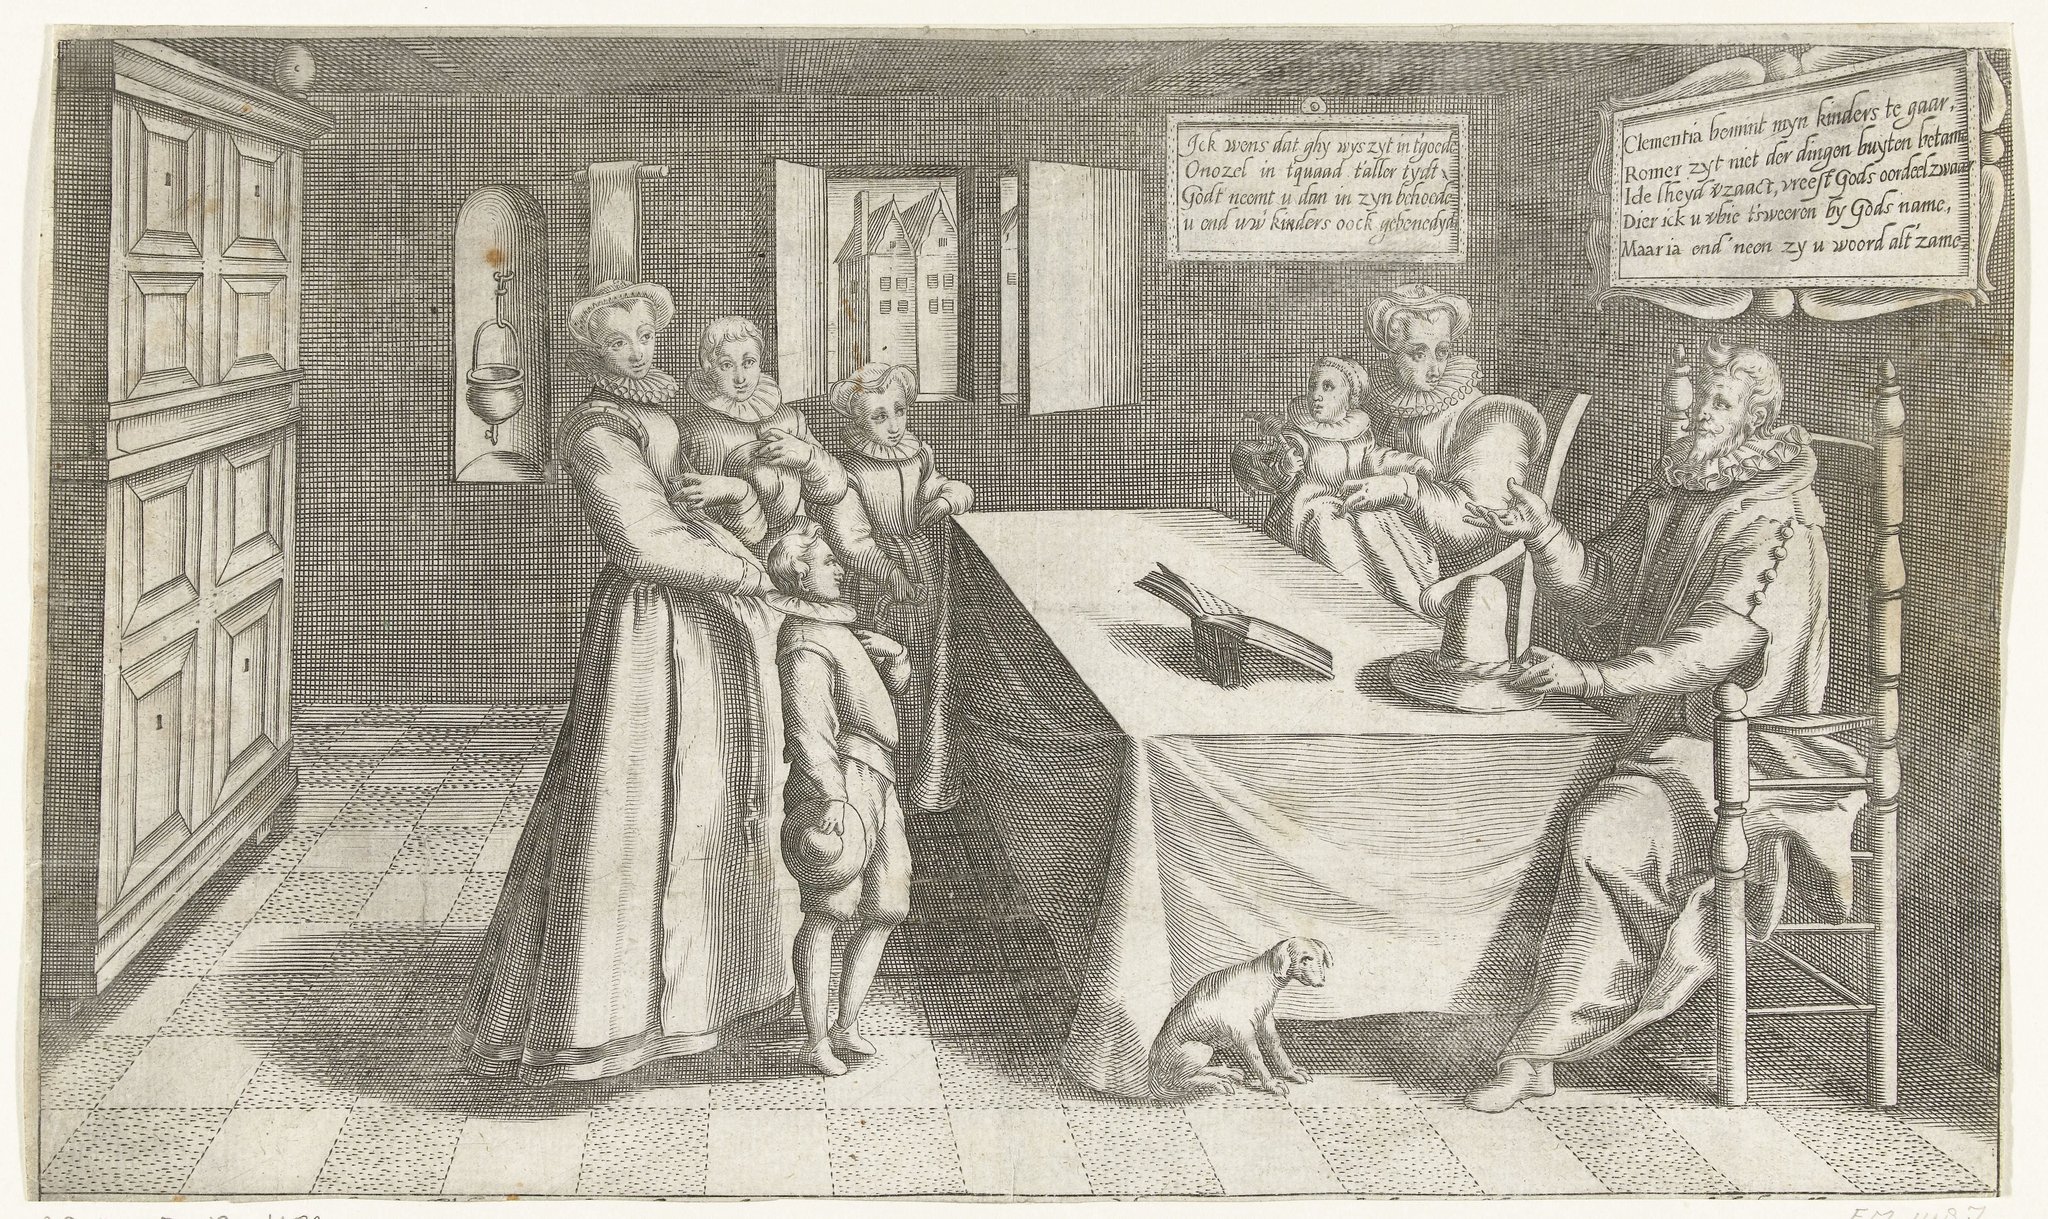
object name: print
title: De goede huisvader, ca. 1600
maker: Anonymous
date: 1600-1649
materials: paper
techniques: engraving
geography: northern netherlands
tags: father with son(s) and daughter(s) (father-love), family group, especially parents with their child(ren), low countries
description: De goede huisvader, ca. 1600. Interieur met een vader gezeten met zijn vrouw achter een tafel waarop een opengeslagen bijbel staat; de vader geeft advies en goede raad aan zijn vier kinderen die voor hem staan. Boven de man en vrouw twee cartouches met vermaningen in het Nederlands.